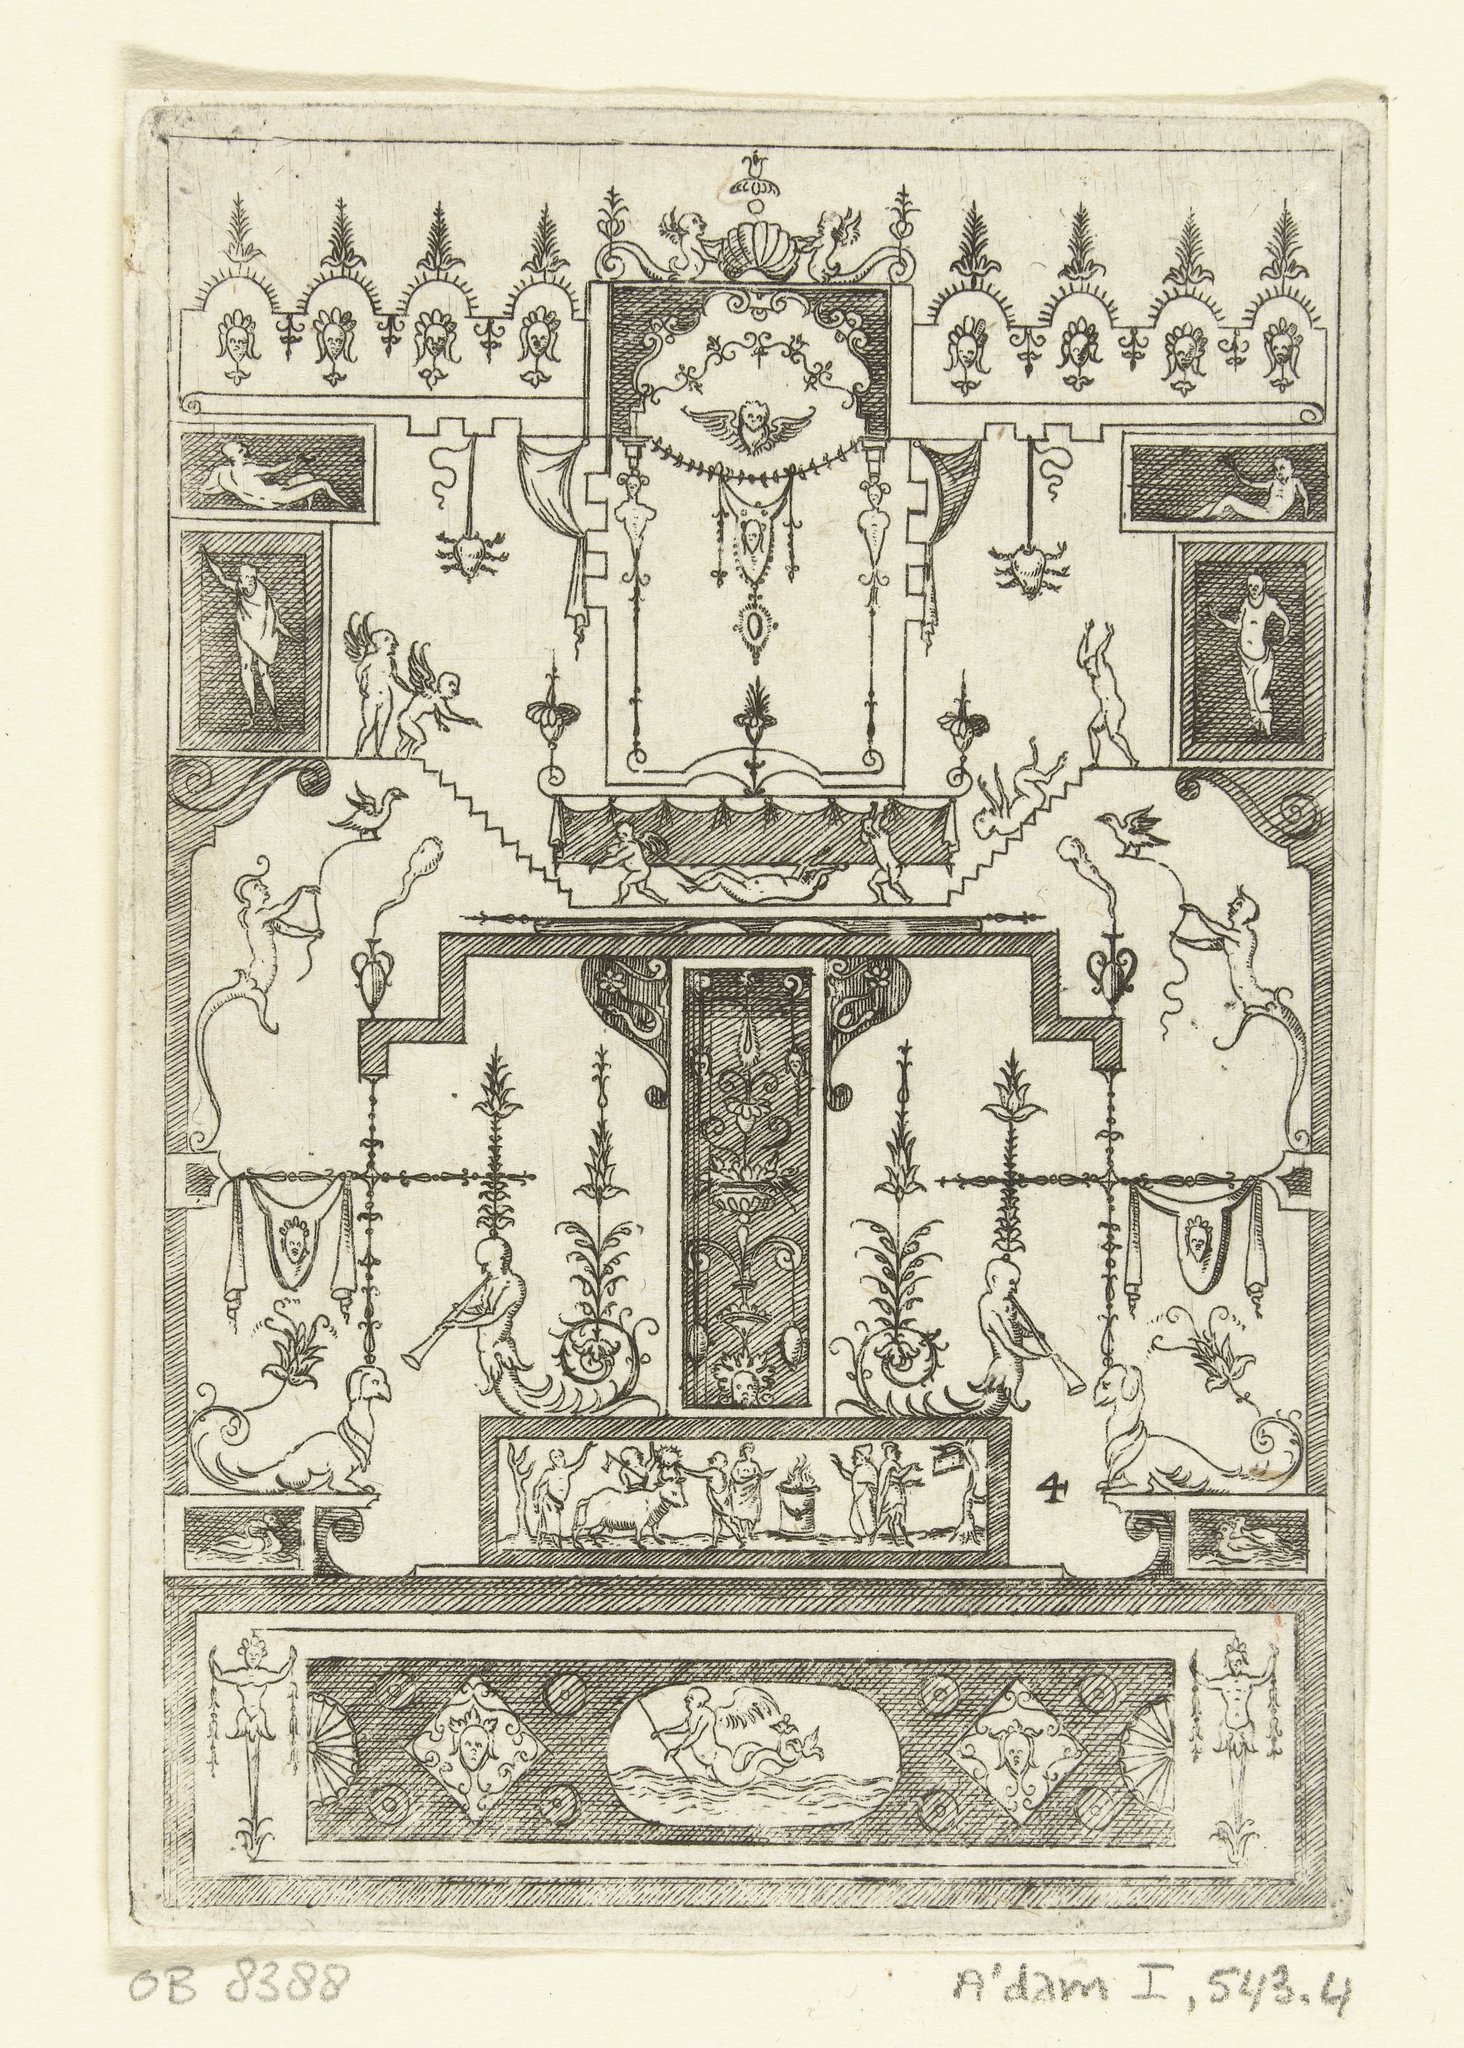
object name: ornament print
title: Iacobus Androuetius Du Cerceau inventor ante annos non paucos conscripsit (...)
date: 1525-1594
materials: paper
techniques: etching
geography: netherlands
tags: monsters ~ swimming mammals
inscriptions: collector's mark: Lugt 240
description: Gelijkzijdige kopie naar prent van Jacques Androuet Ducerceau, ontleend aan een vlakdecoratie van Enea Vico. Blad uit serie met architectuurfantasieën en grotesken met fabelwezens, guirlandes, kandelabers en mascarons.